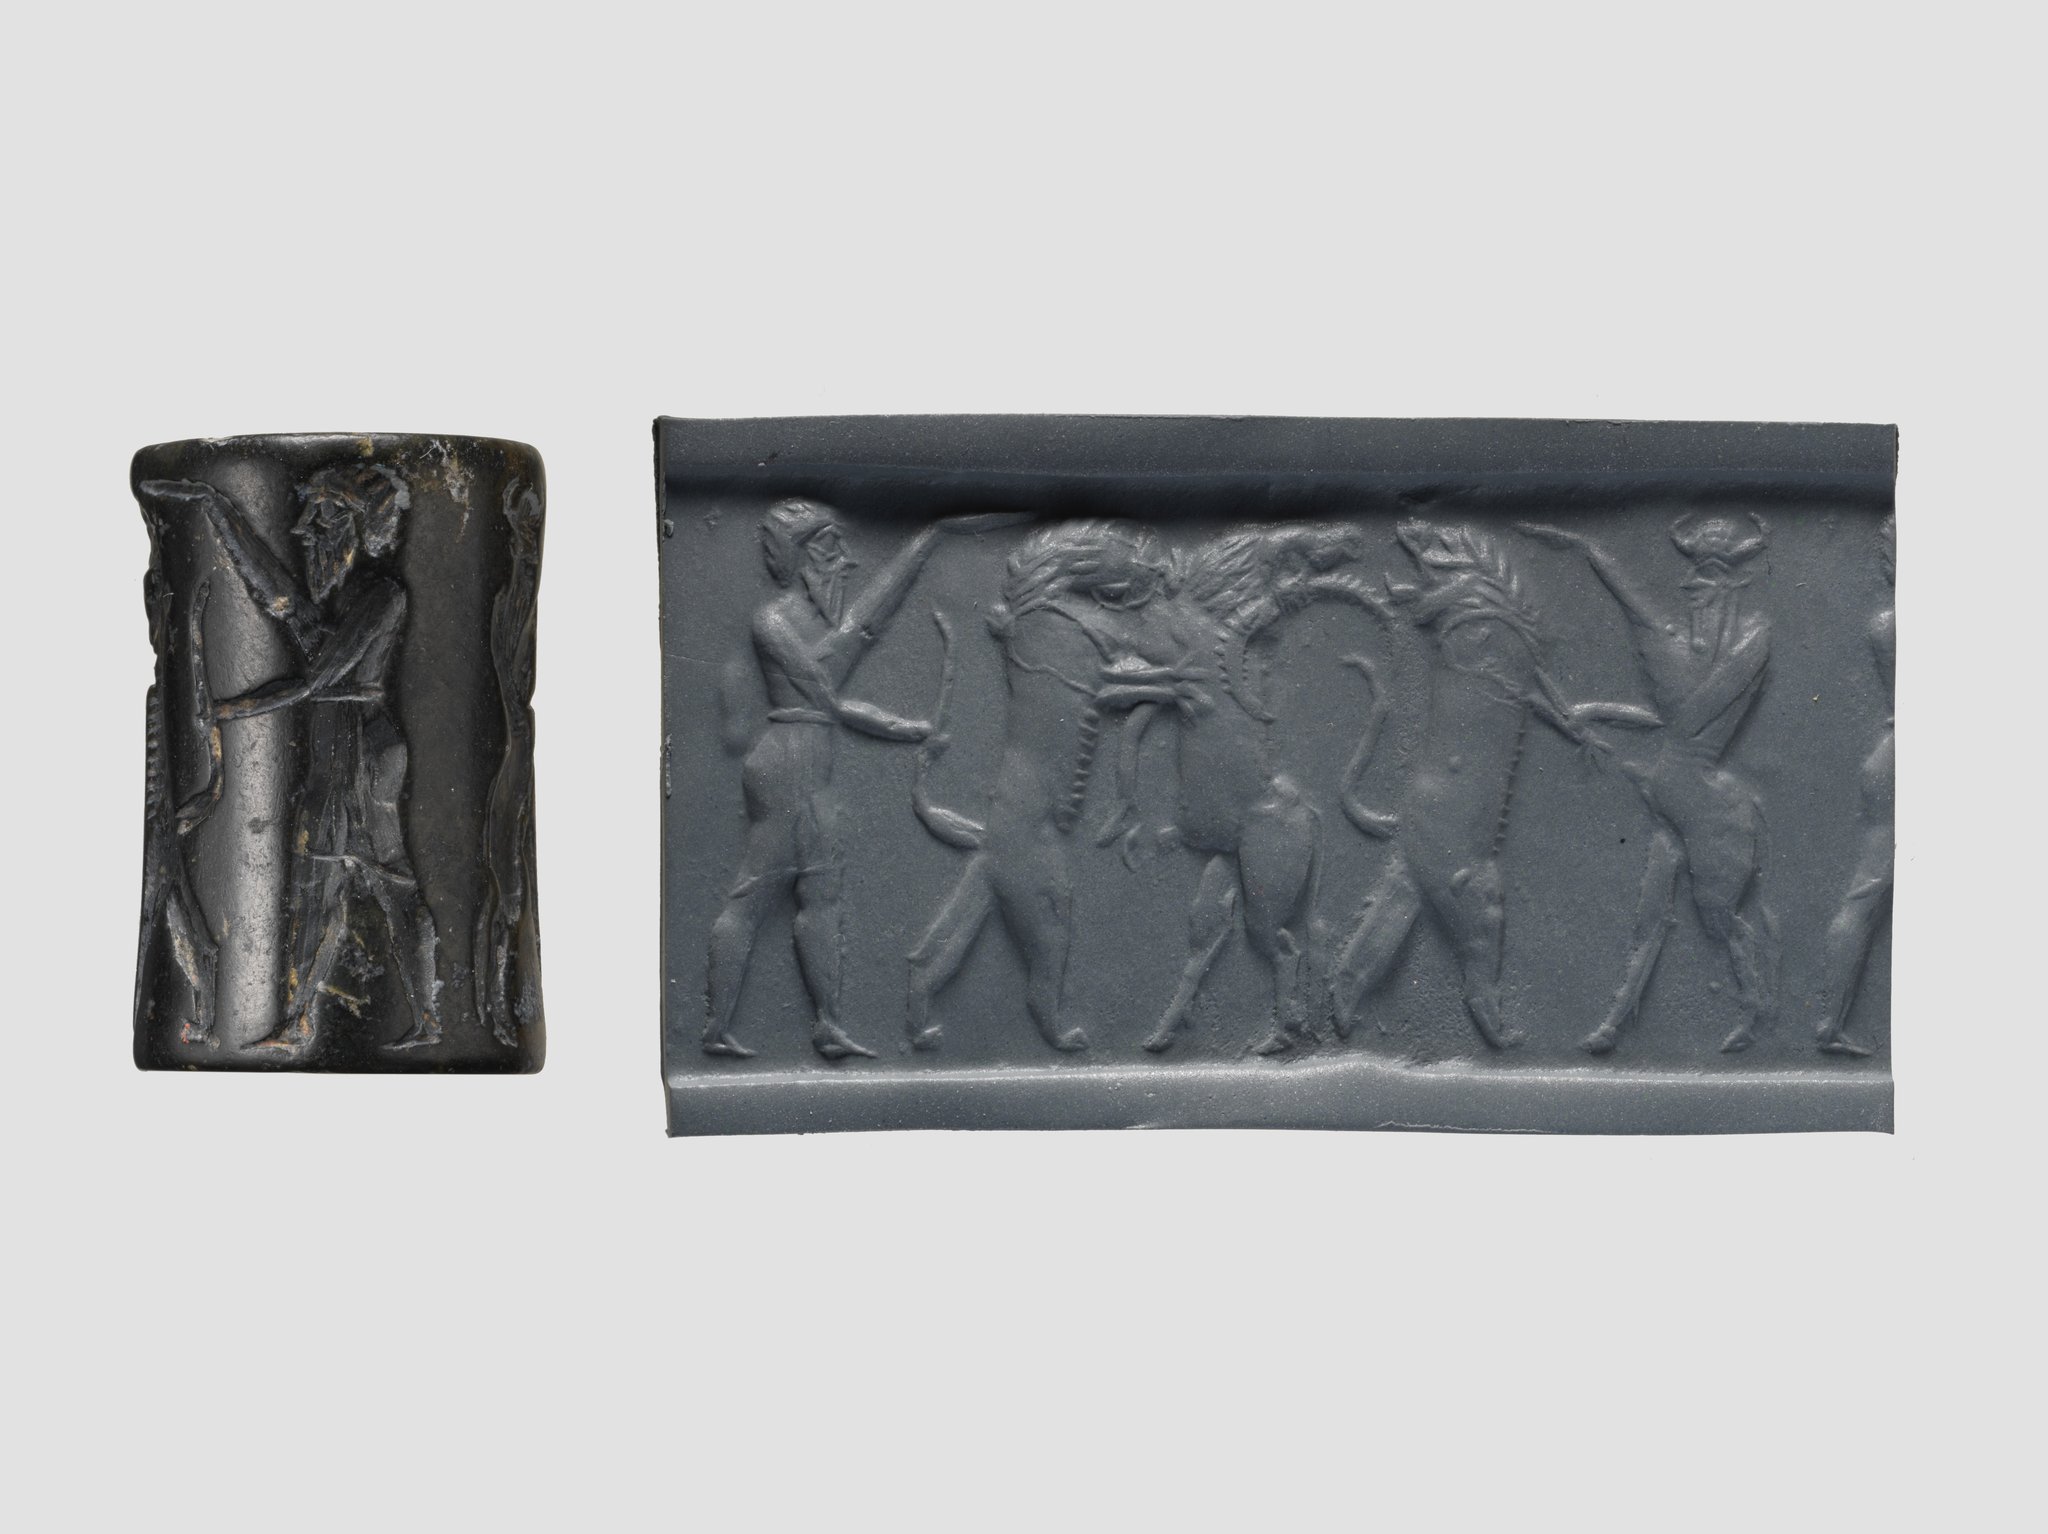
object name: cylinder seal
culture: akkadian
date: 2350-2250 BCE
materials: stone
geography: mesopotamia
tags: animals